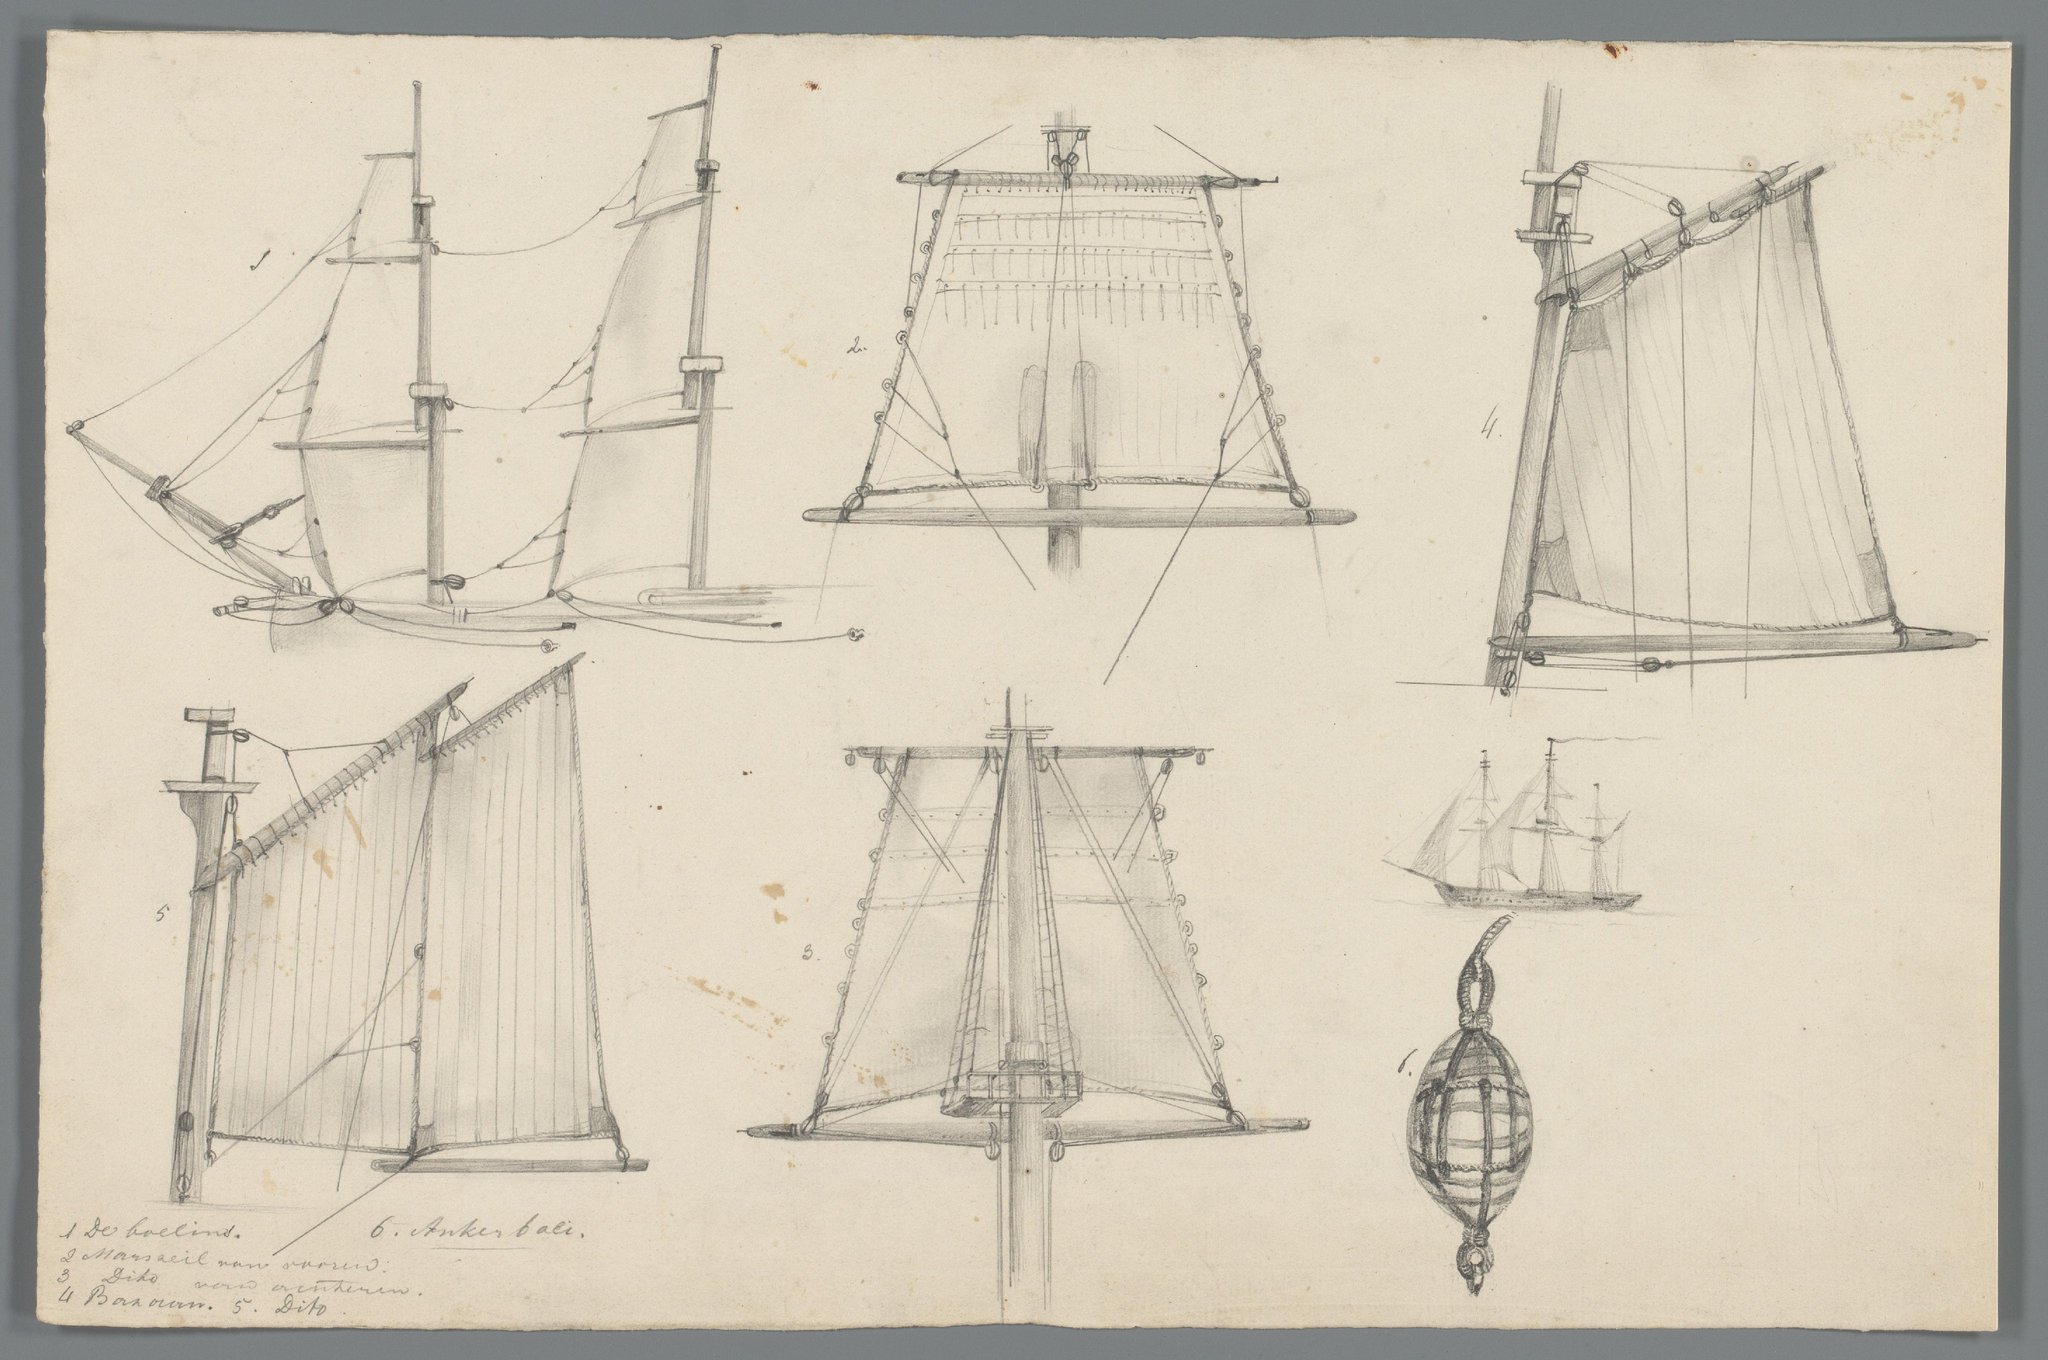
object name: drawing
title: Zeilen en tuigage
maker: willem anthonie van deventer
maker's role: draughtsman, painter, print maker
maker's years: 1824-1893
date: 1834-1893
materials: paper, pencil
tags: sailing-ship's rigging